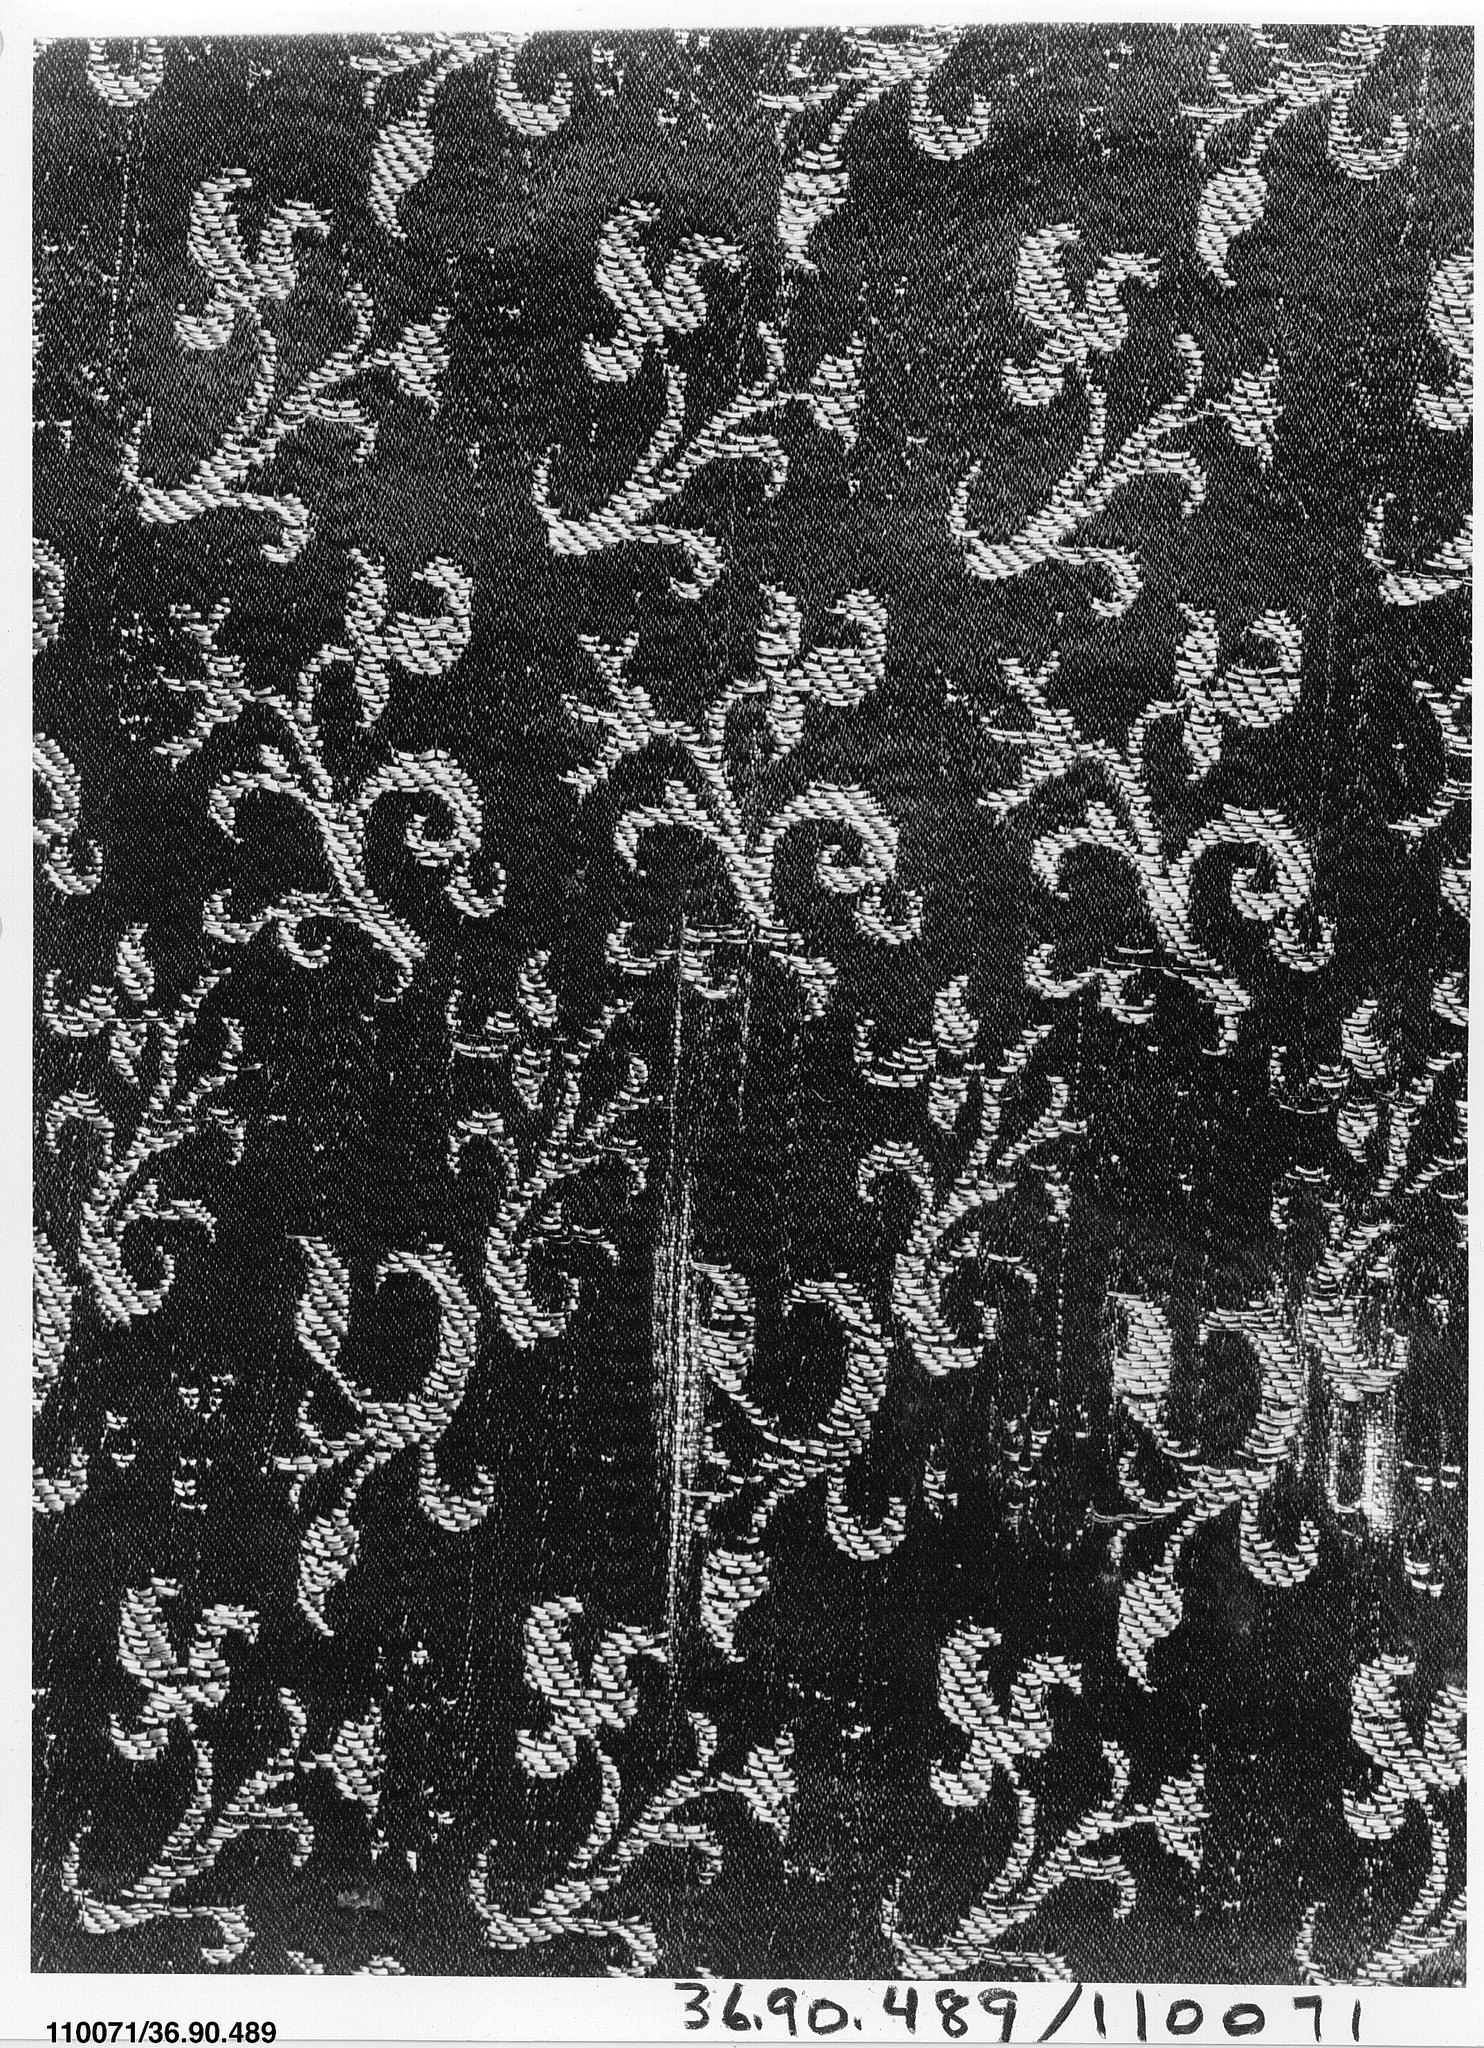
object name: piece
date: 1501-1700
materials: silk